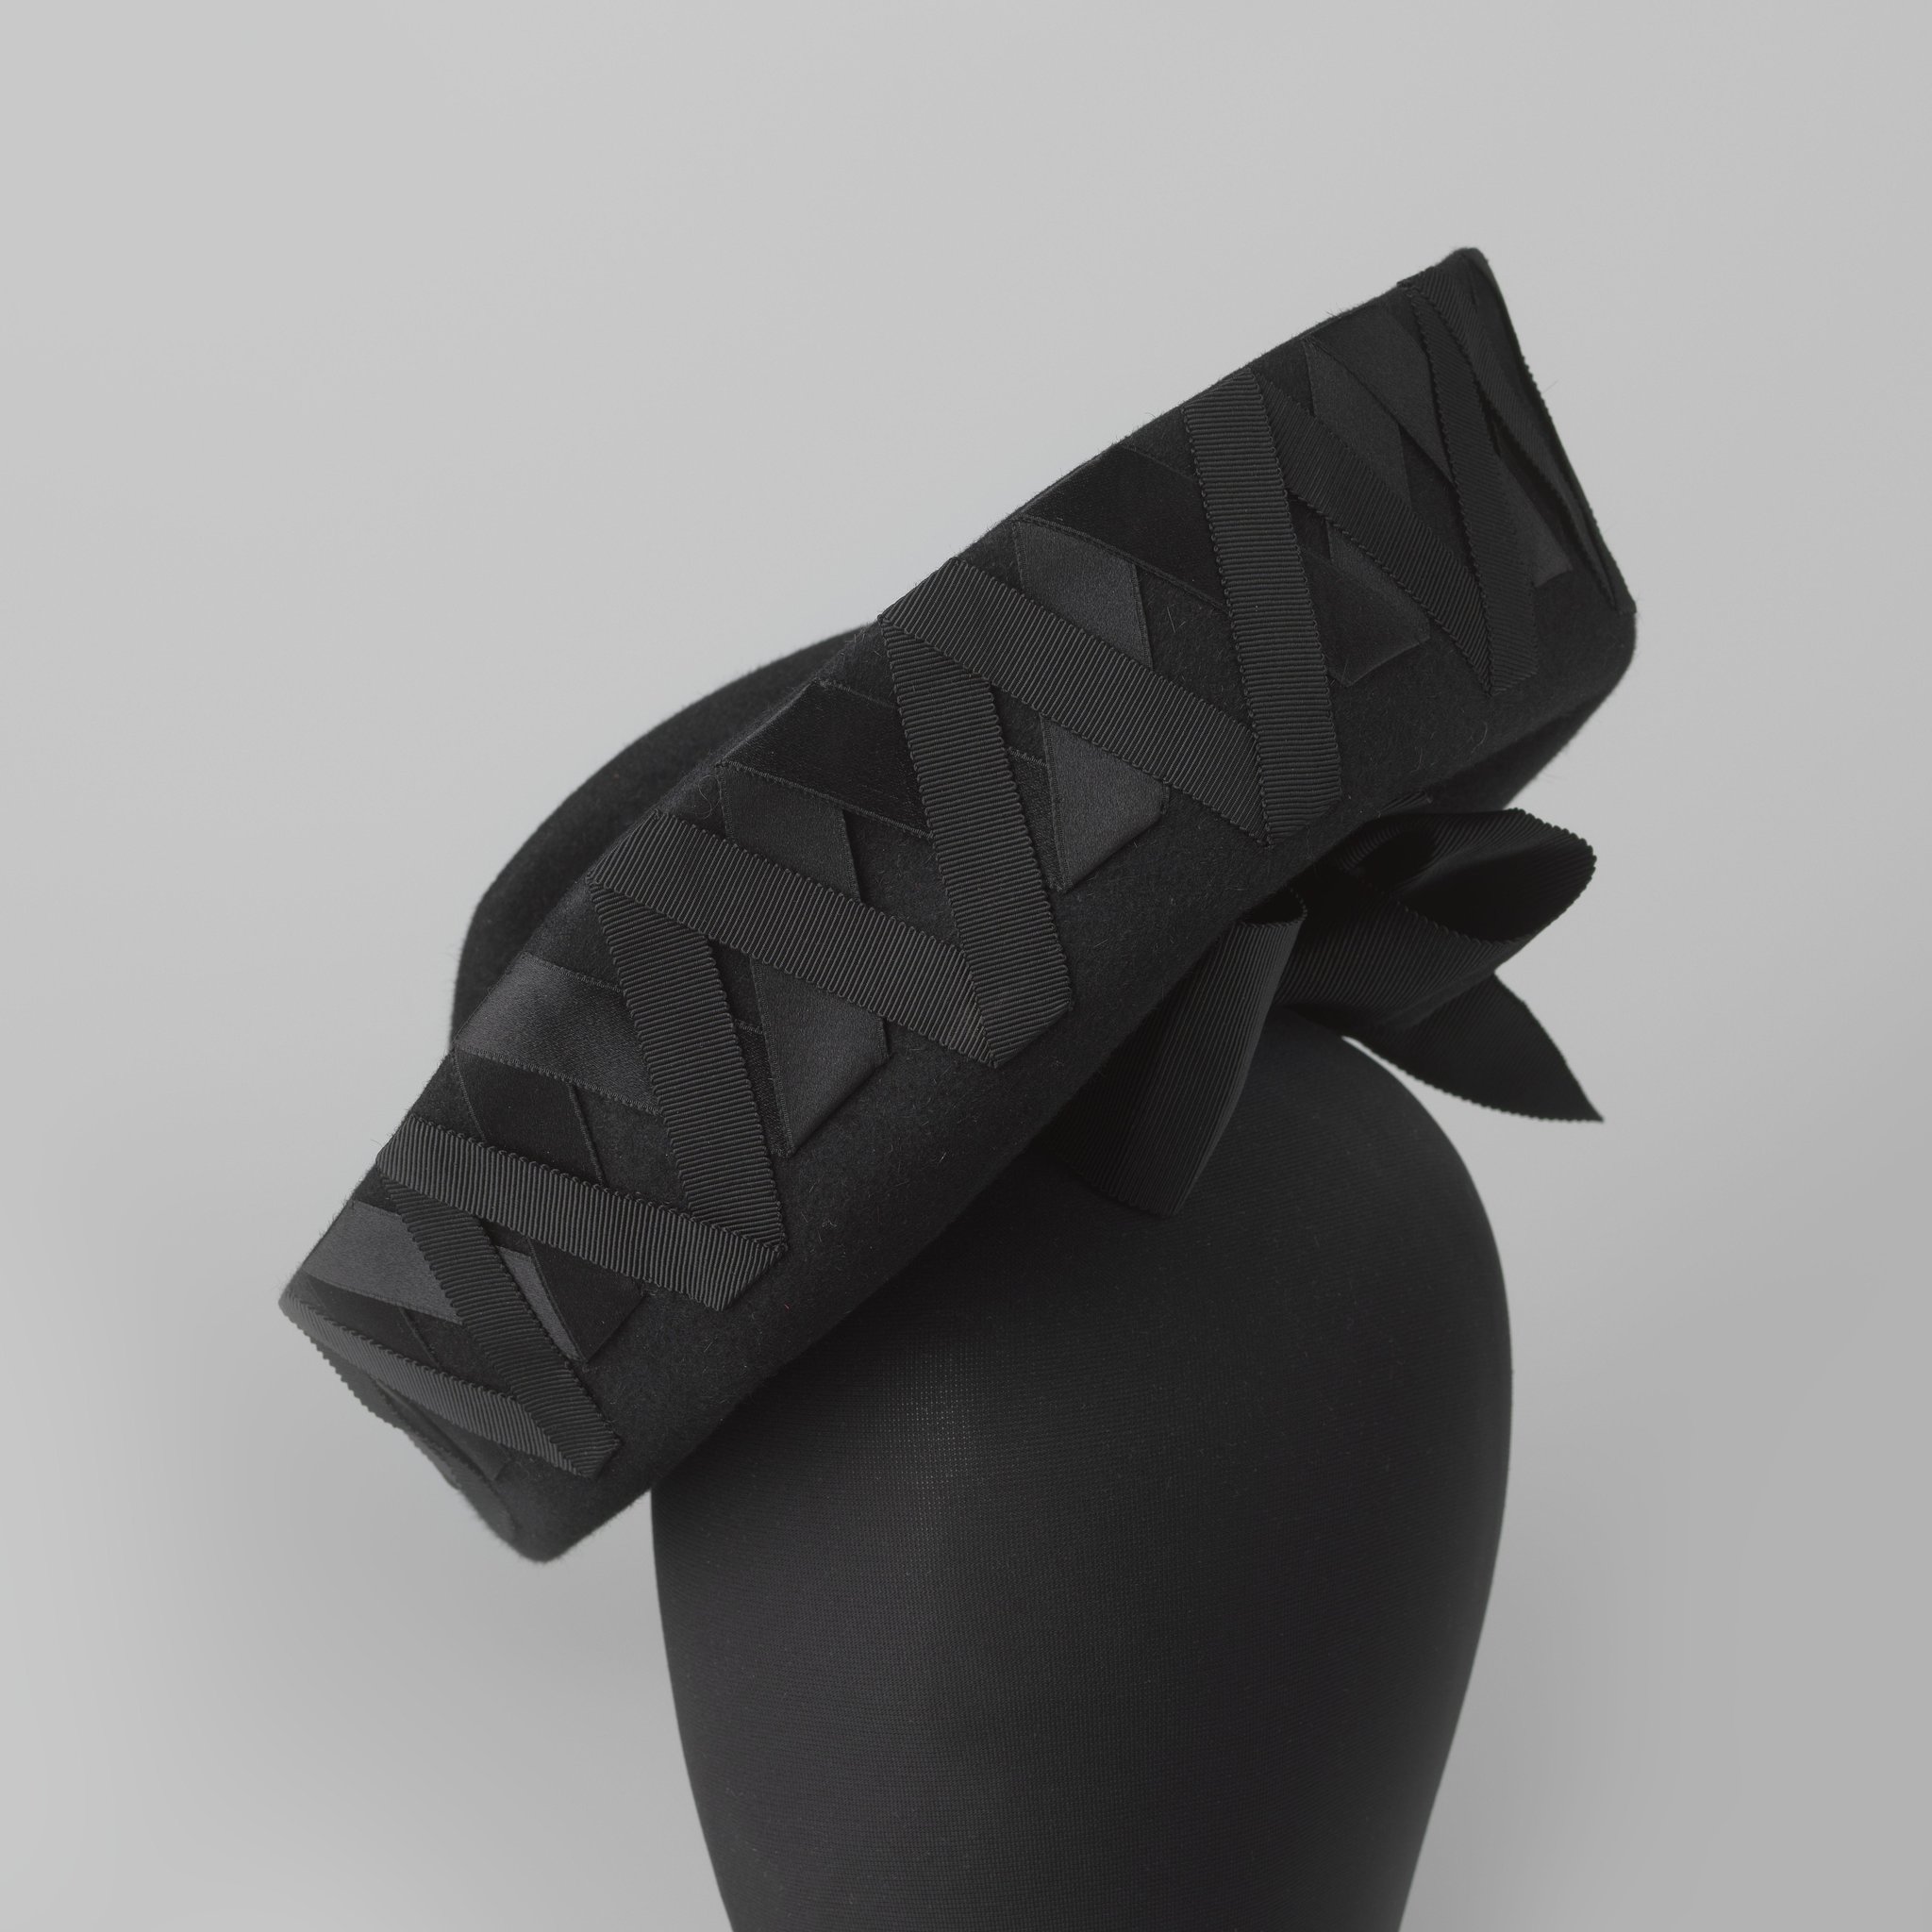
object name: hat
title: Hoed van zwart vilt met brede opstaande rand, versierd met kruislings geplaatste linten van grosgrain en satijn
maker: janette colombier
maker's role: hoedenmaakster, modiste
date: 1946-1950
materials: felt, textile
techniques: weave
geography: paris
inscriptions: label: ‘JANETTE COLOMBIER // 4. AV. MATIGNON - PARIS’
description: Hoed van zwart vilt met brede opstaande rand, versierd met kruislings geplaatste linten van grosgrain en satijn. Aan de binnenzijde van de hoed een label waarop de naam en het adres van de modiste.